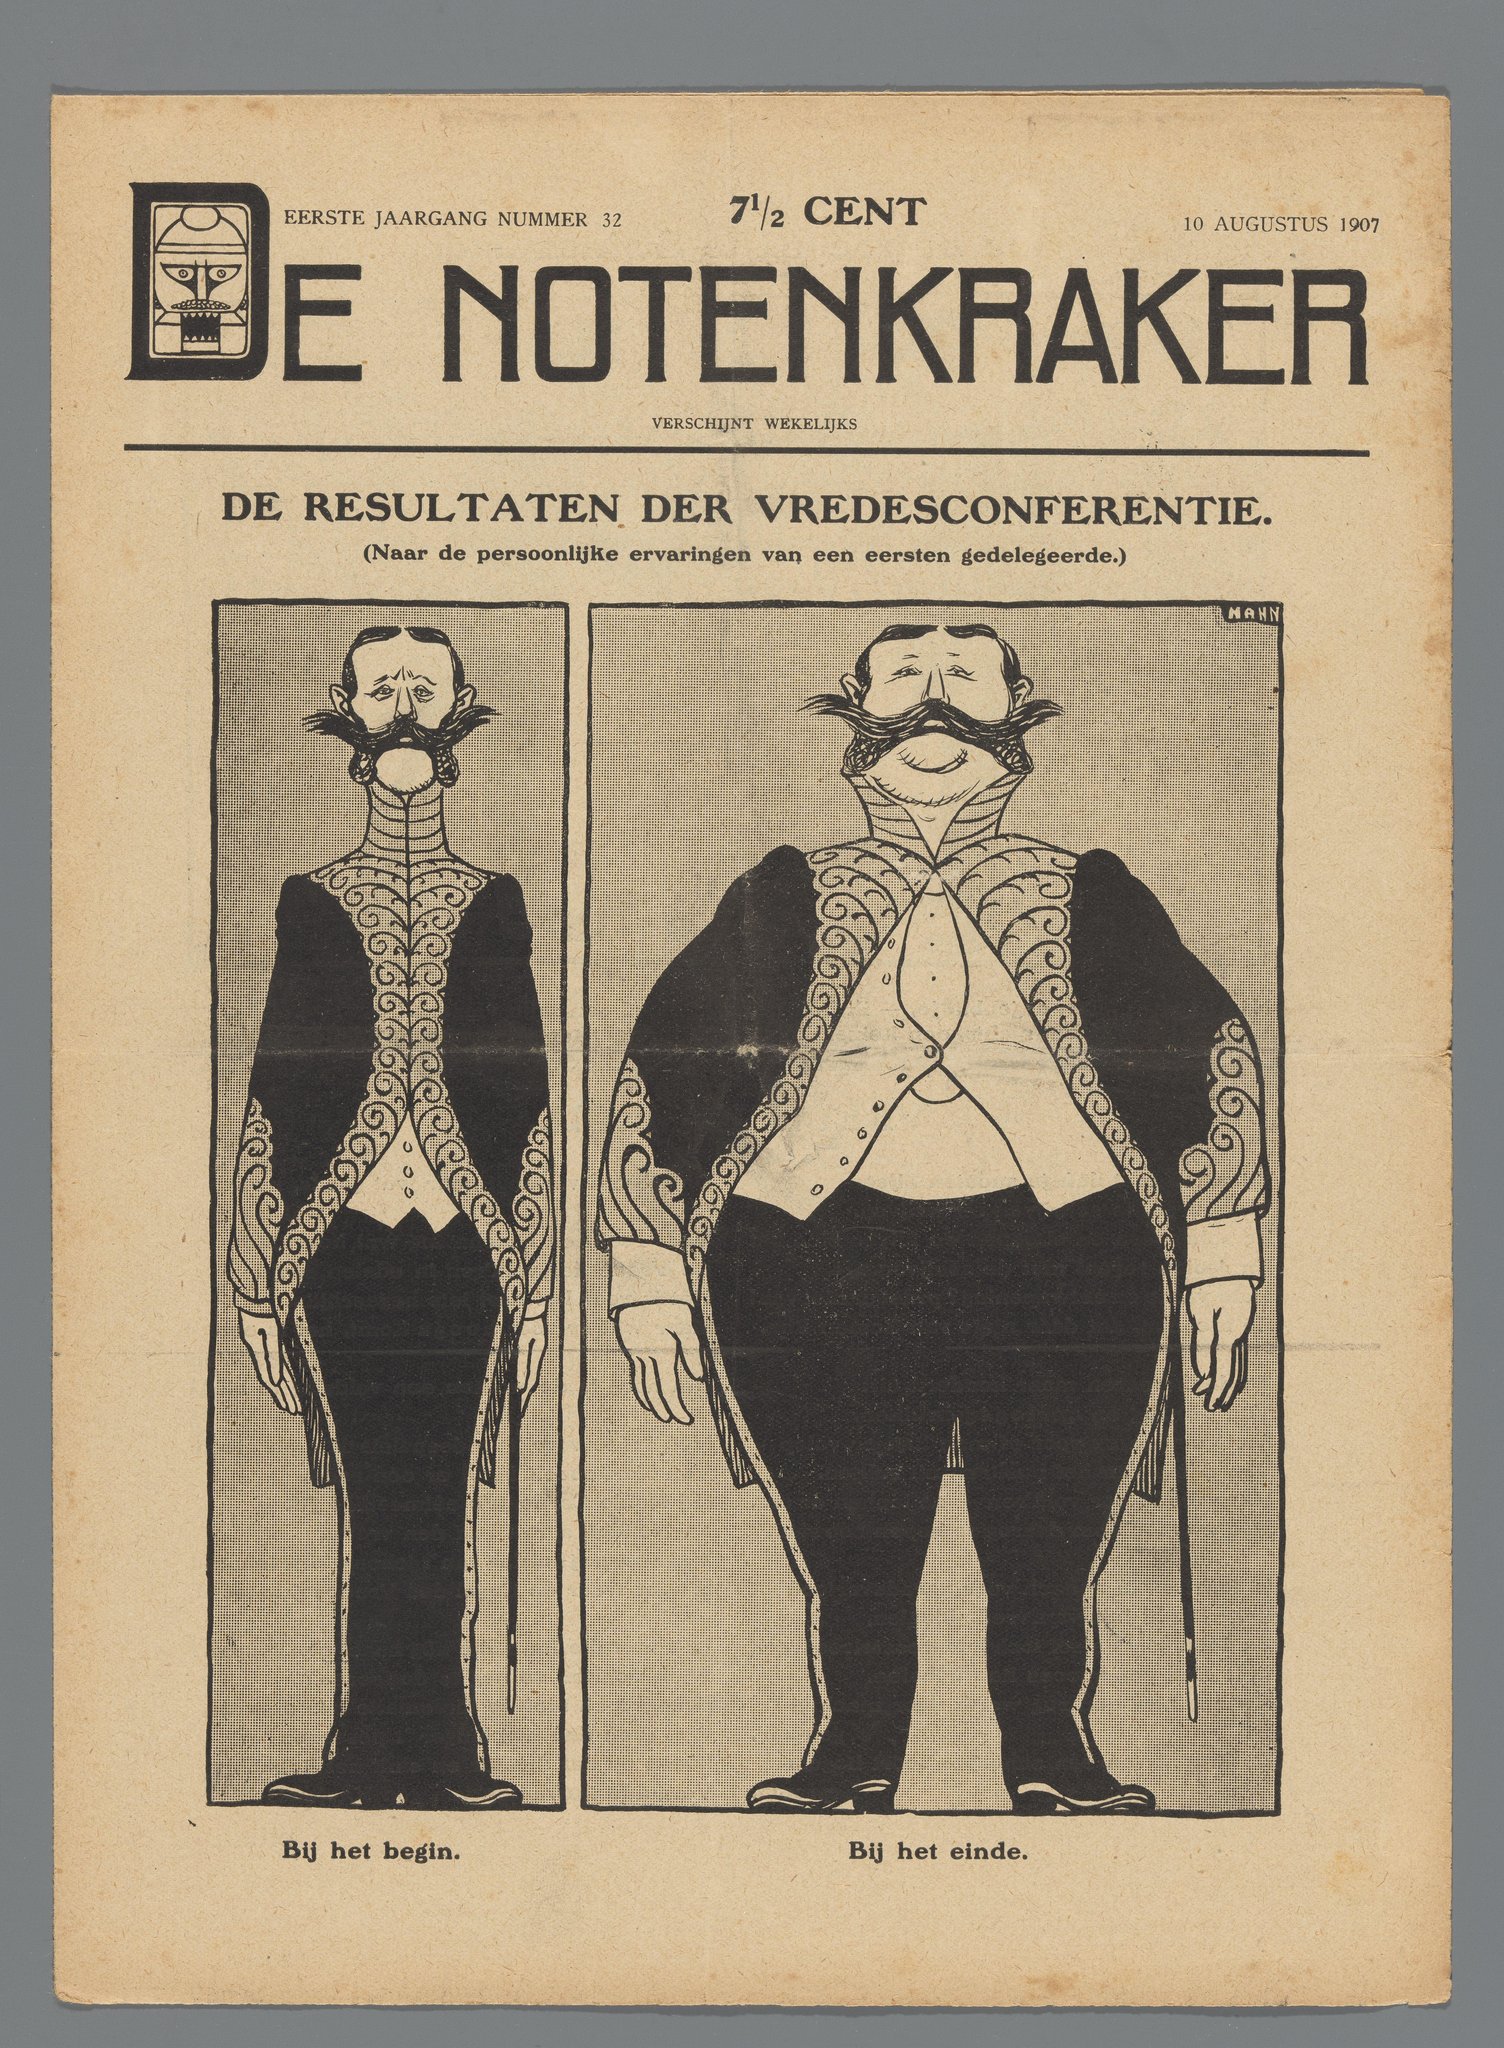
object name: print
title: De Notenkraker, 10 augustus 1907 / De resultaten der vredesconferentie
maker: albert hahn (i)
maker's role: draughtsman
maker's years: 1877-1918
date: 1907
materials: paper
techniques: lithograph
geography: netherlands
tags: fat (human type), peace negotiations, politician, e.g. party leader, political caricatures and satires, netherlands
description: Aflevering van het satirische tijdschrift De Notenkraker van 10 augustus 1907, eerste jaargang, nummer 32. Omslag met illustratie van een politicus die na de vredesconferentie te Den Haag alleen dikker is geworden. Onderdeel van een volledige eerste jaargang (1907). Elk nummer bevat 8 bladzijden, deels nog niet losgesneden, met op de voorzijde steeds een spotprent van Albert Hahn, op de overige pagina's prenten van Hahn steeds tussen de tekst. In de letter 'D' van de titel is een kop van een zgn. notenkraker afgebeeld.